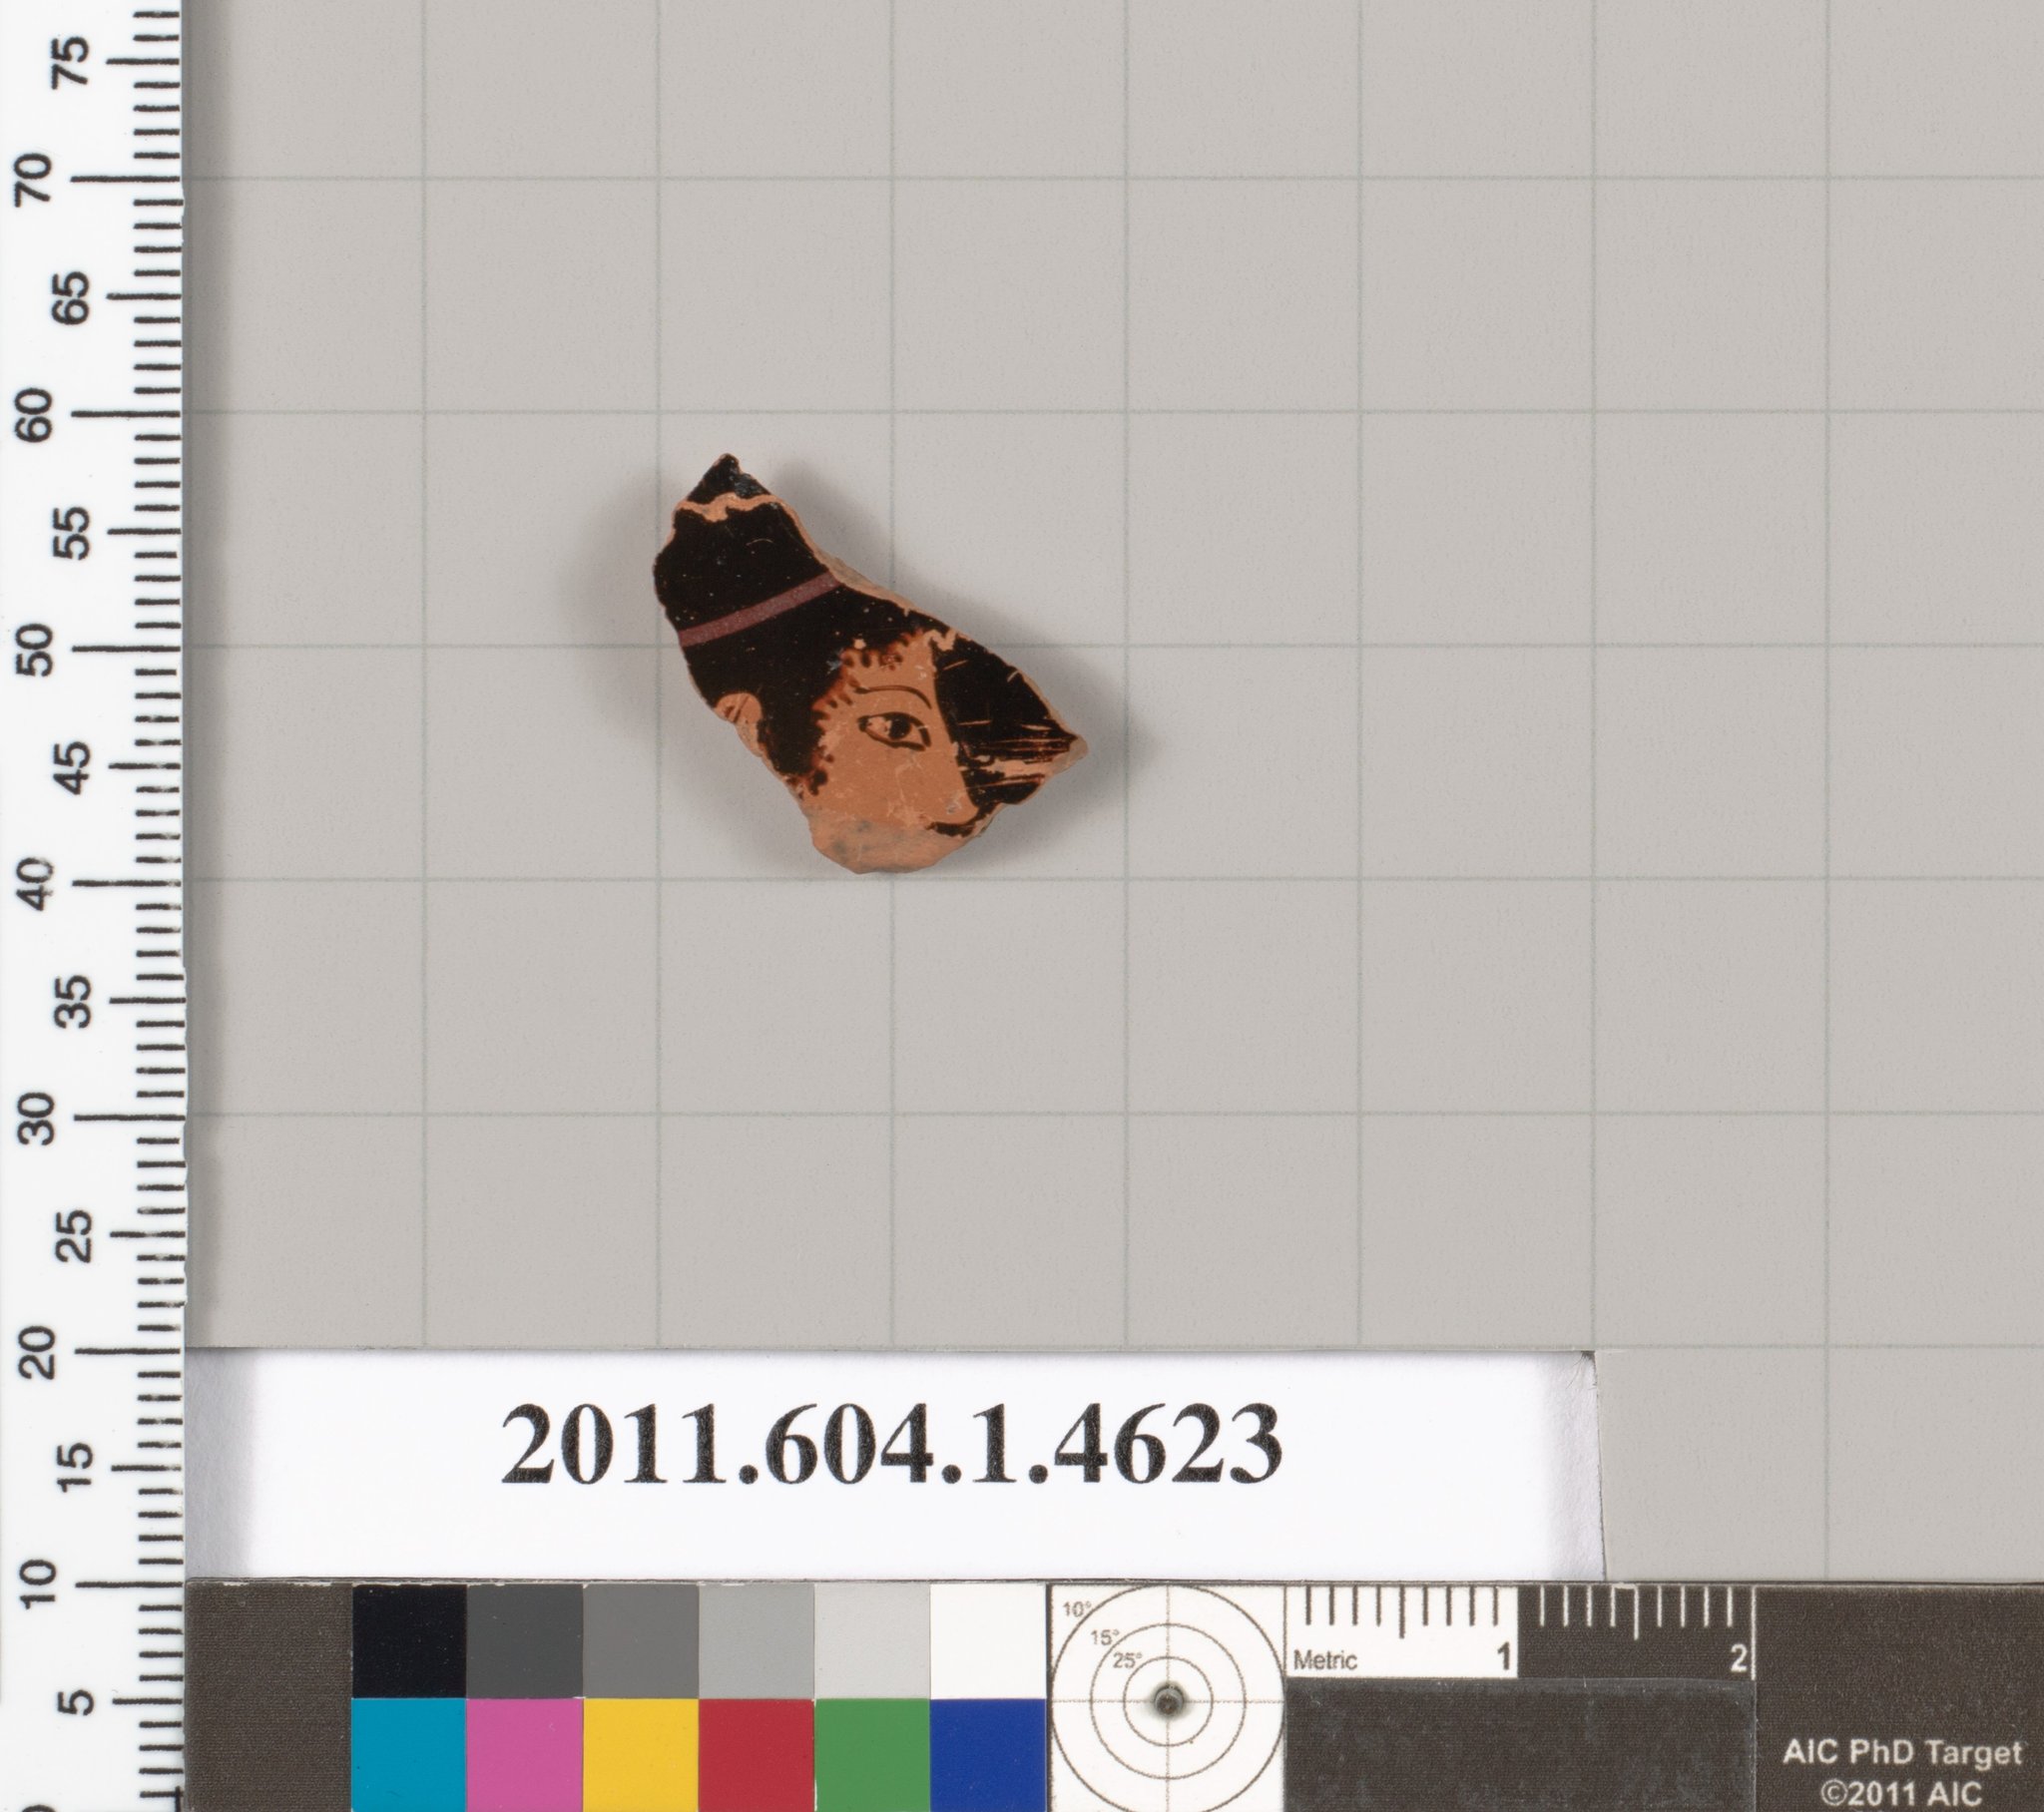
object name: kylix fragment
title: Terracotta fragment of a kylix (drinking cup)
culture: greek, attic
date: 520-500 BCE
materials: terracotta